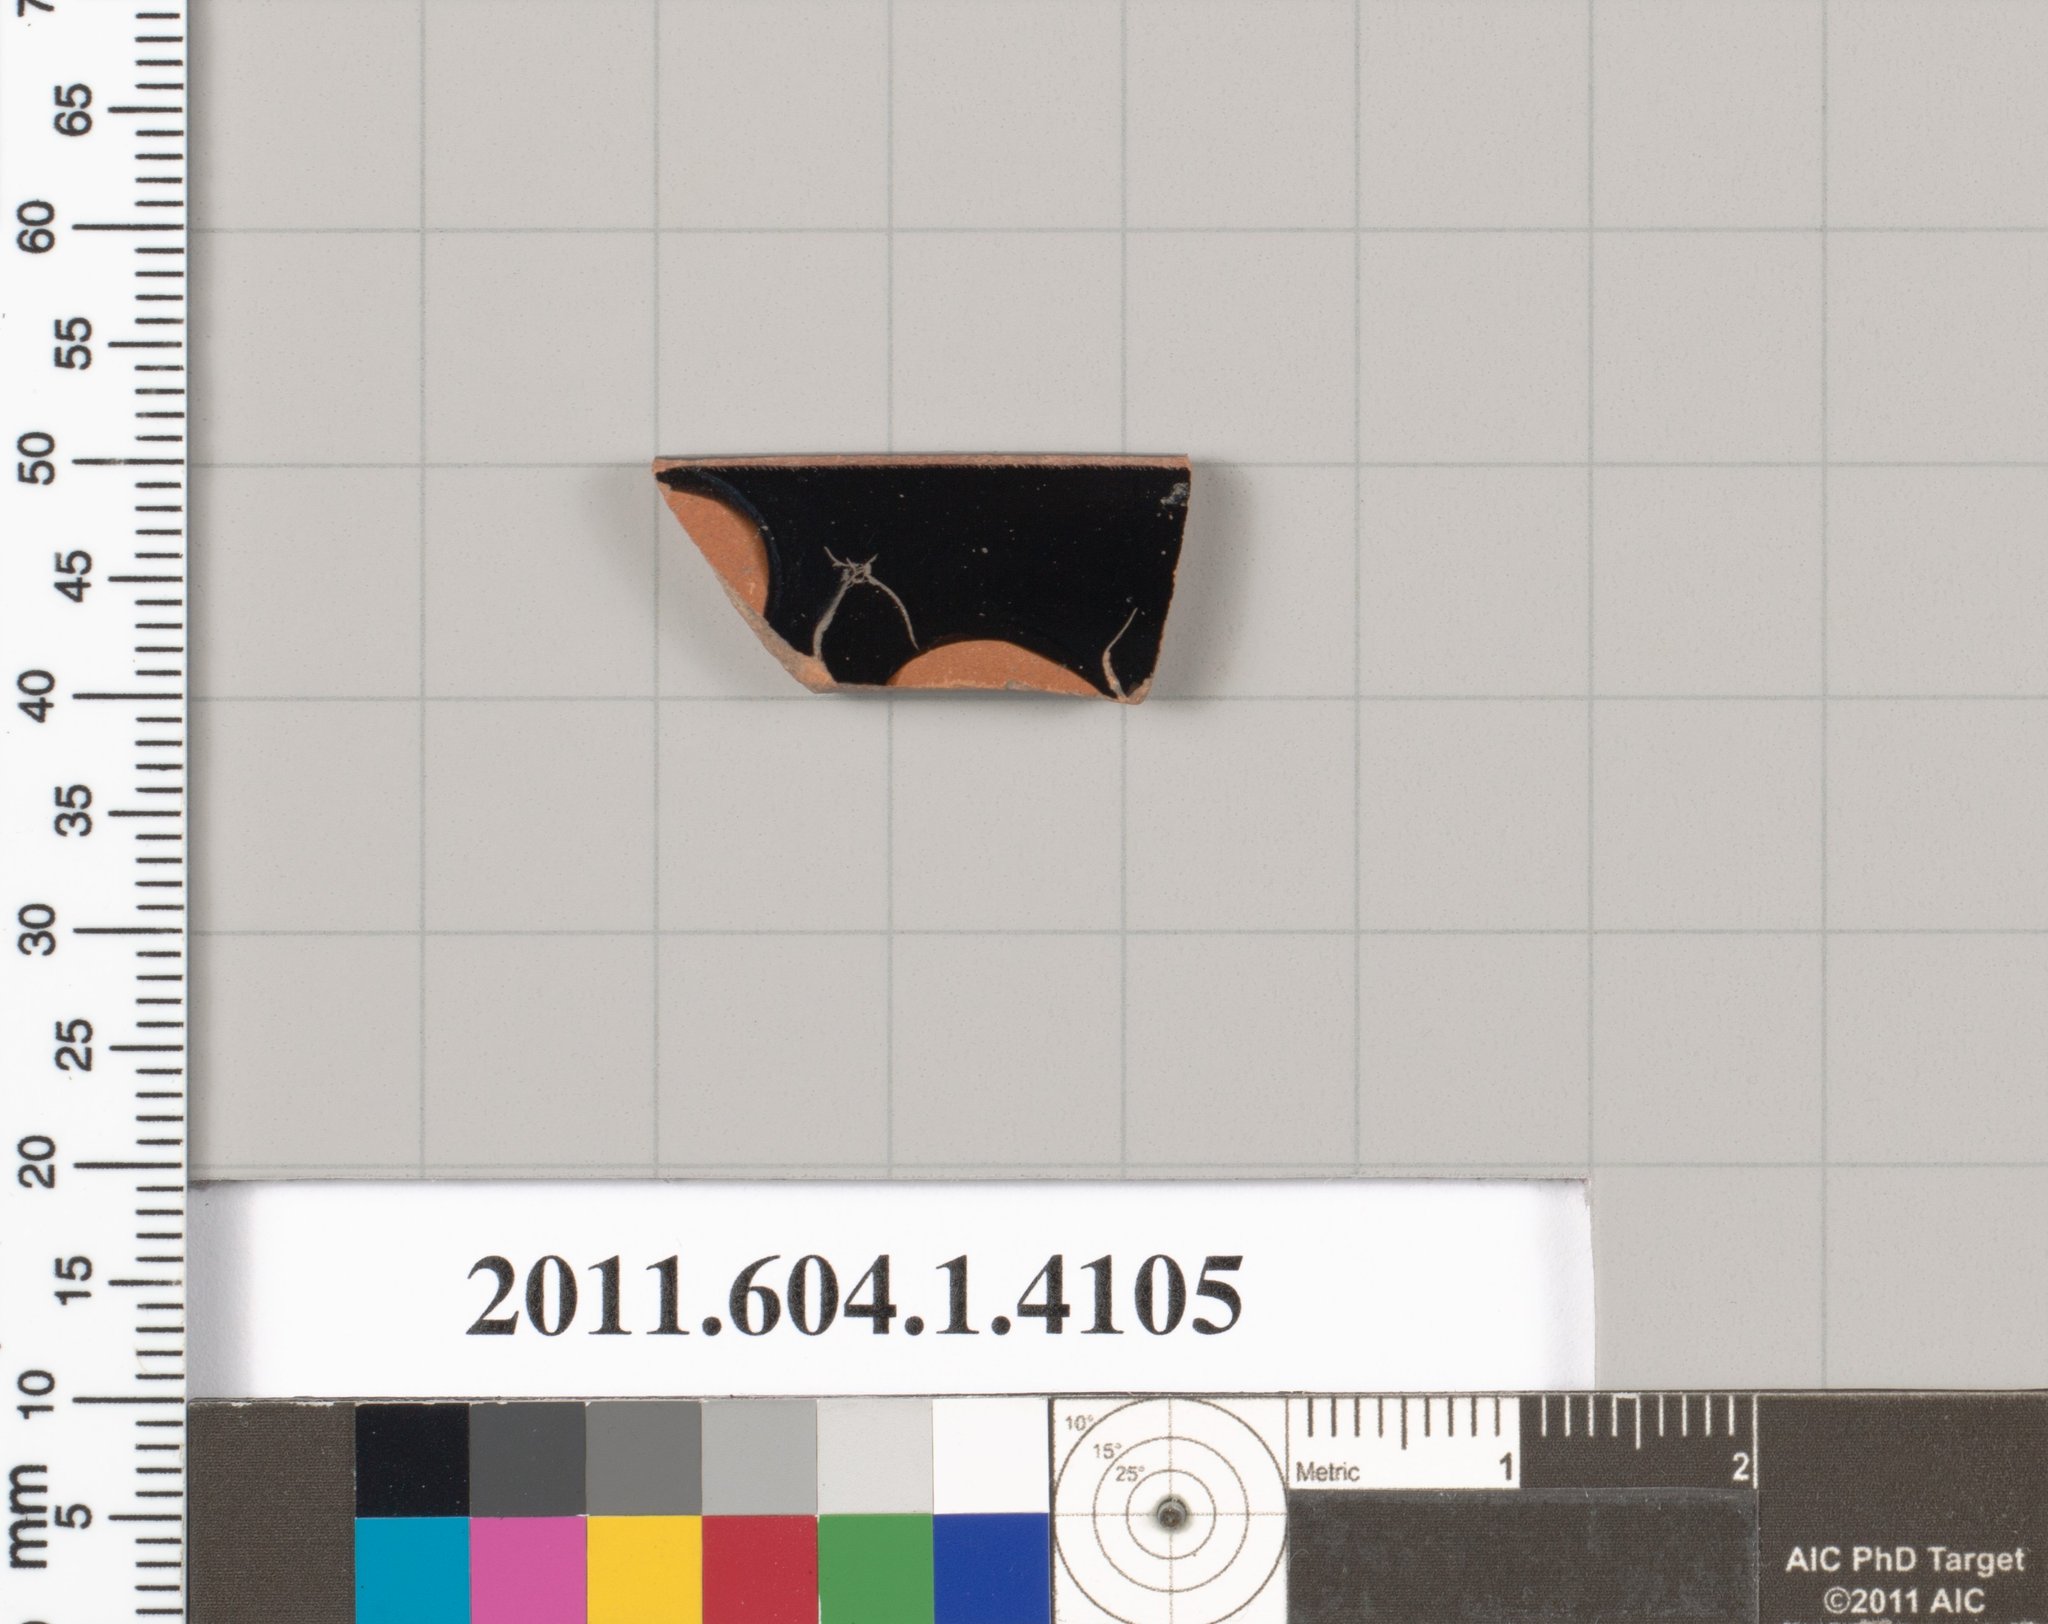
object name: kylix fragment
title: Terracotta rim fragment of a kylix (drinking cup)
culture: greek, attic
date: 520-490 BCE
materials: terracotta